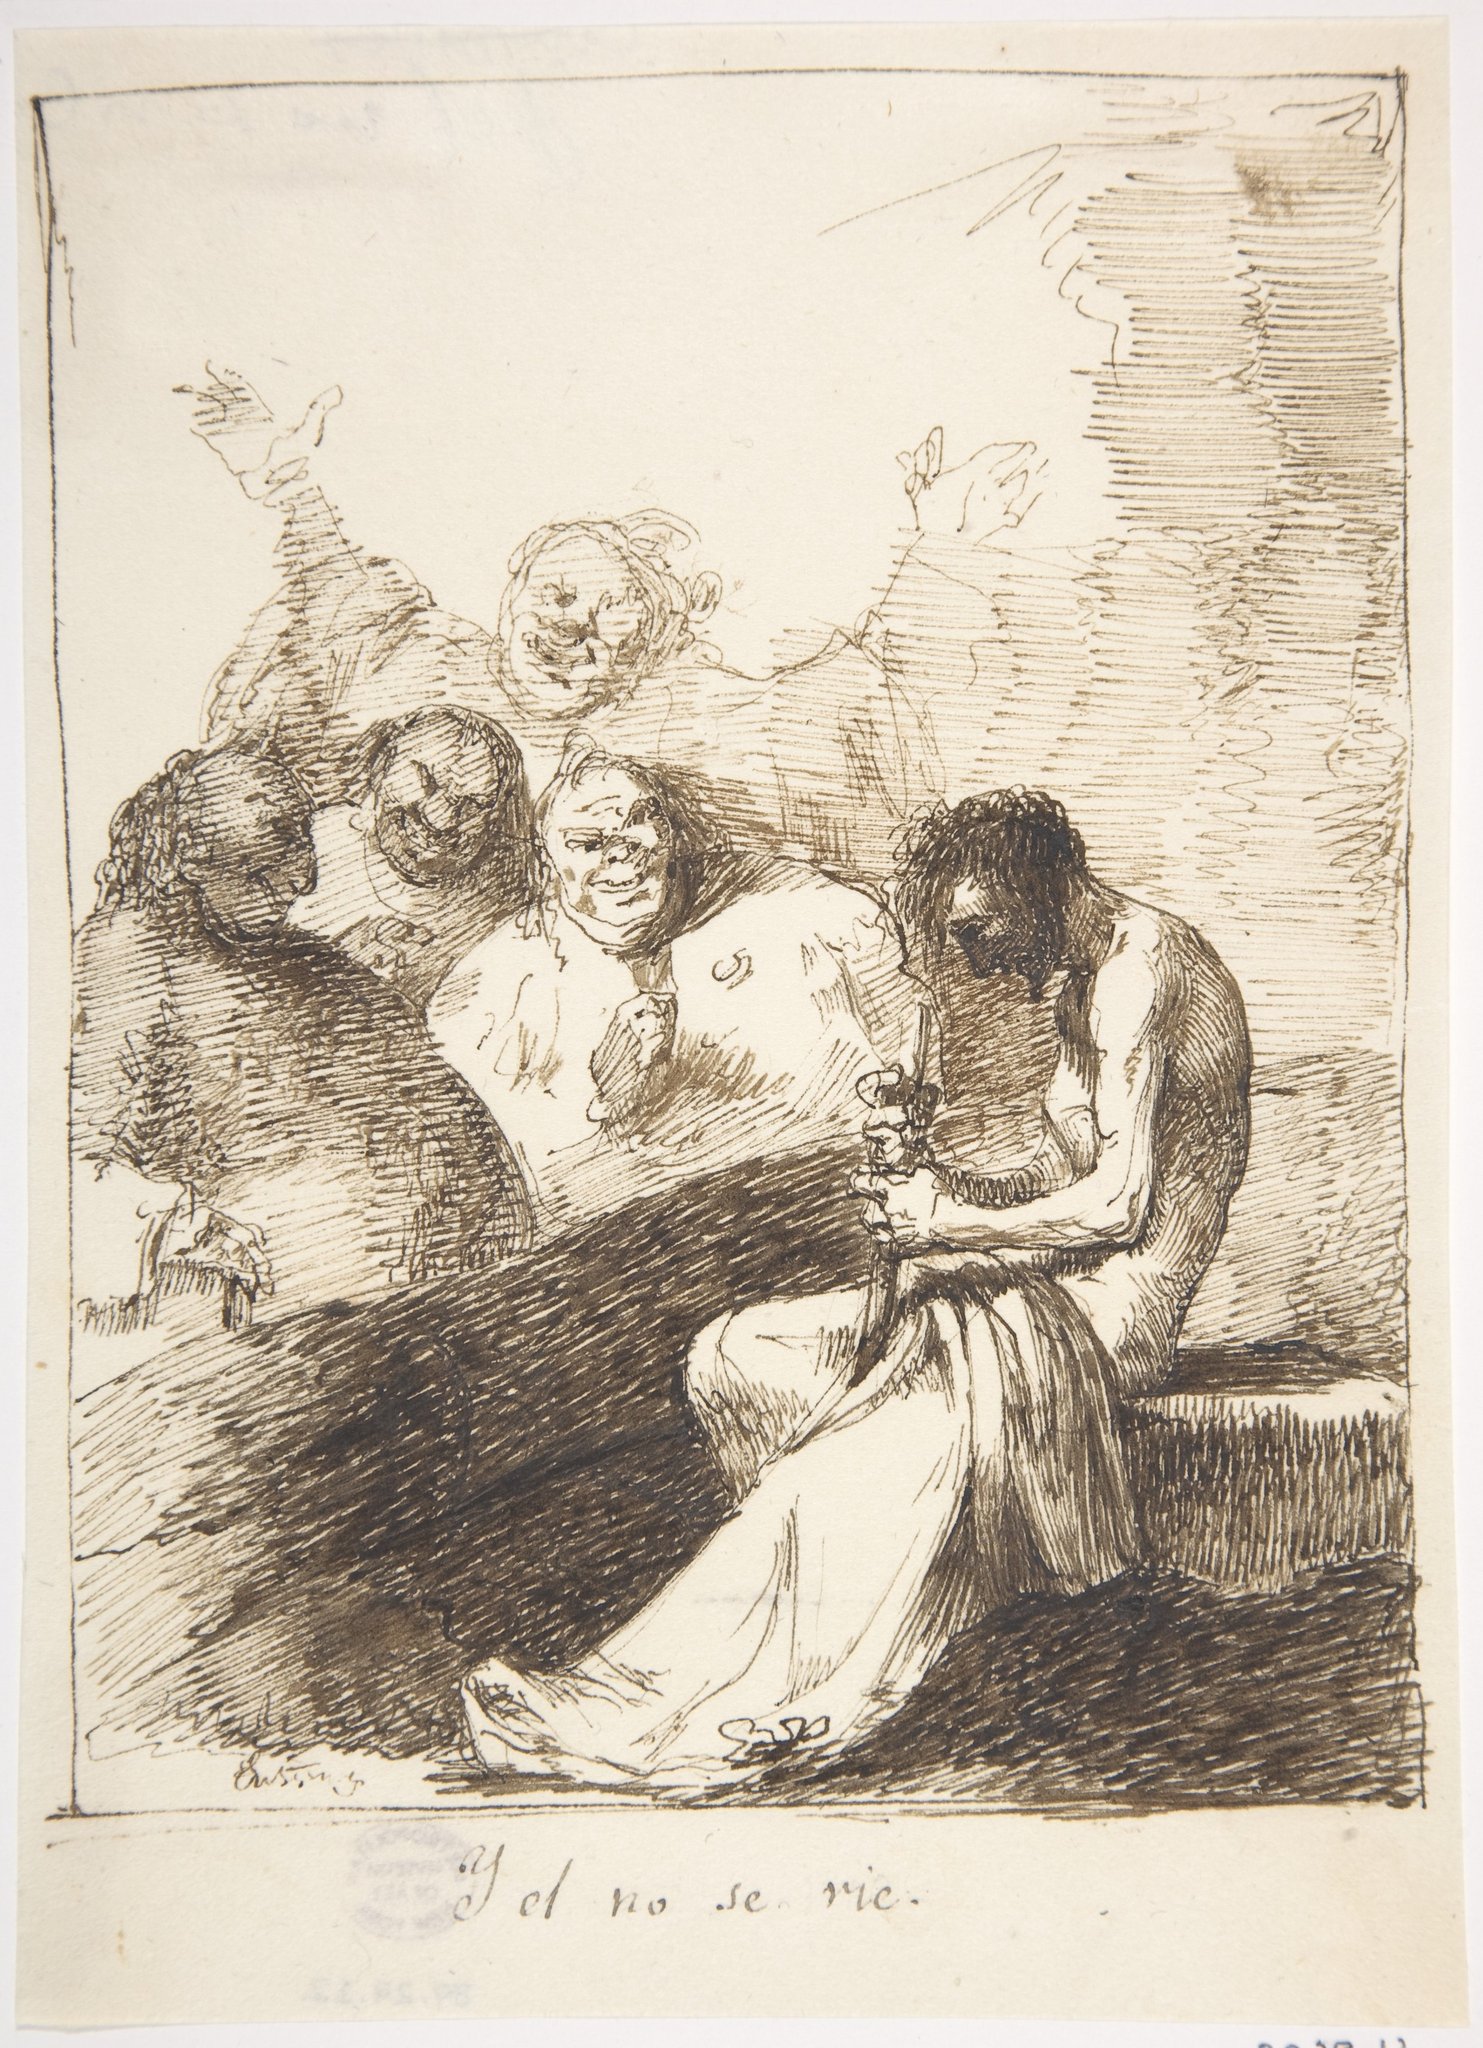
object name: drawing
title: He Will Not Laugh (Y el no se rie)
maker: leonardo alenza y nieto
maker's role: artist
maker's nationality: spanish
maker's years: 1807-1845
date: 1807-1845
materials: ink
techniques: pen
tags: sadness,men